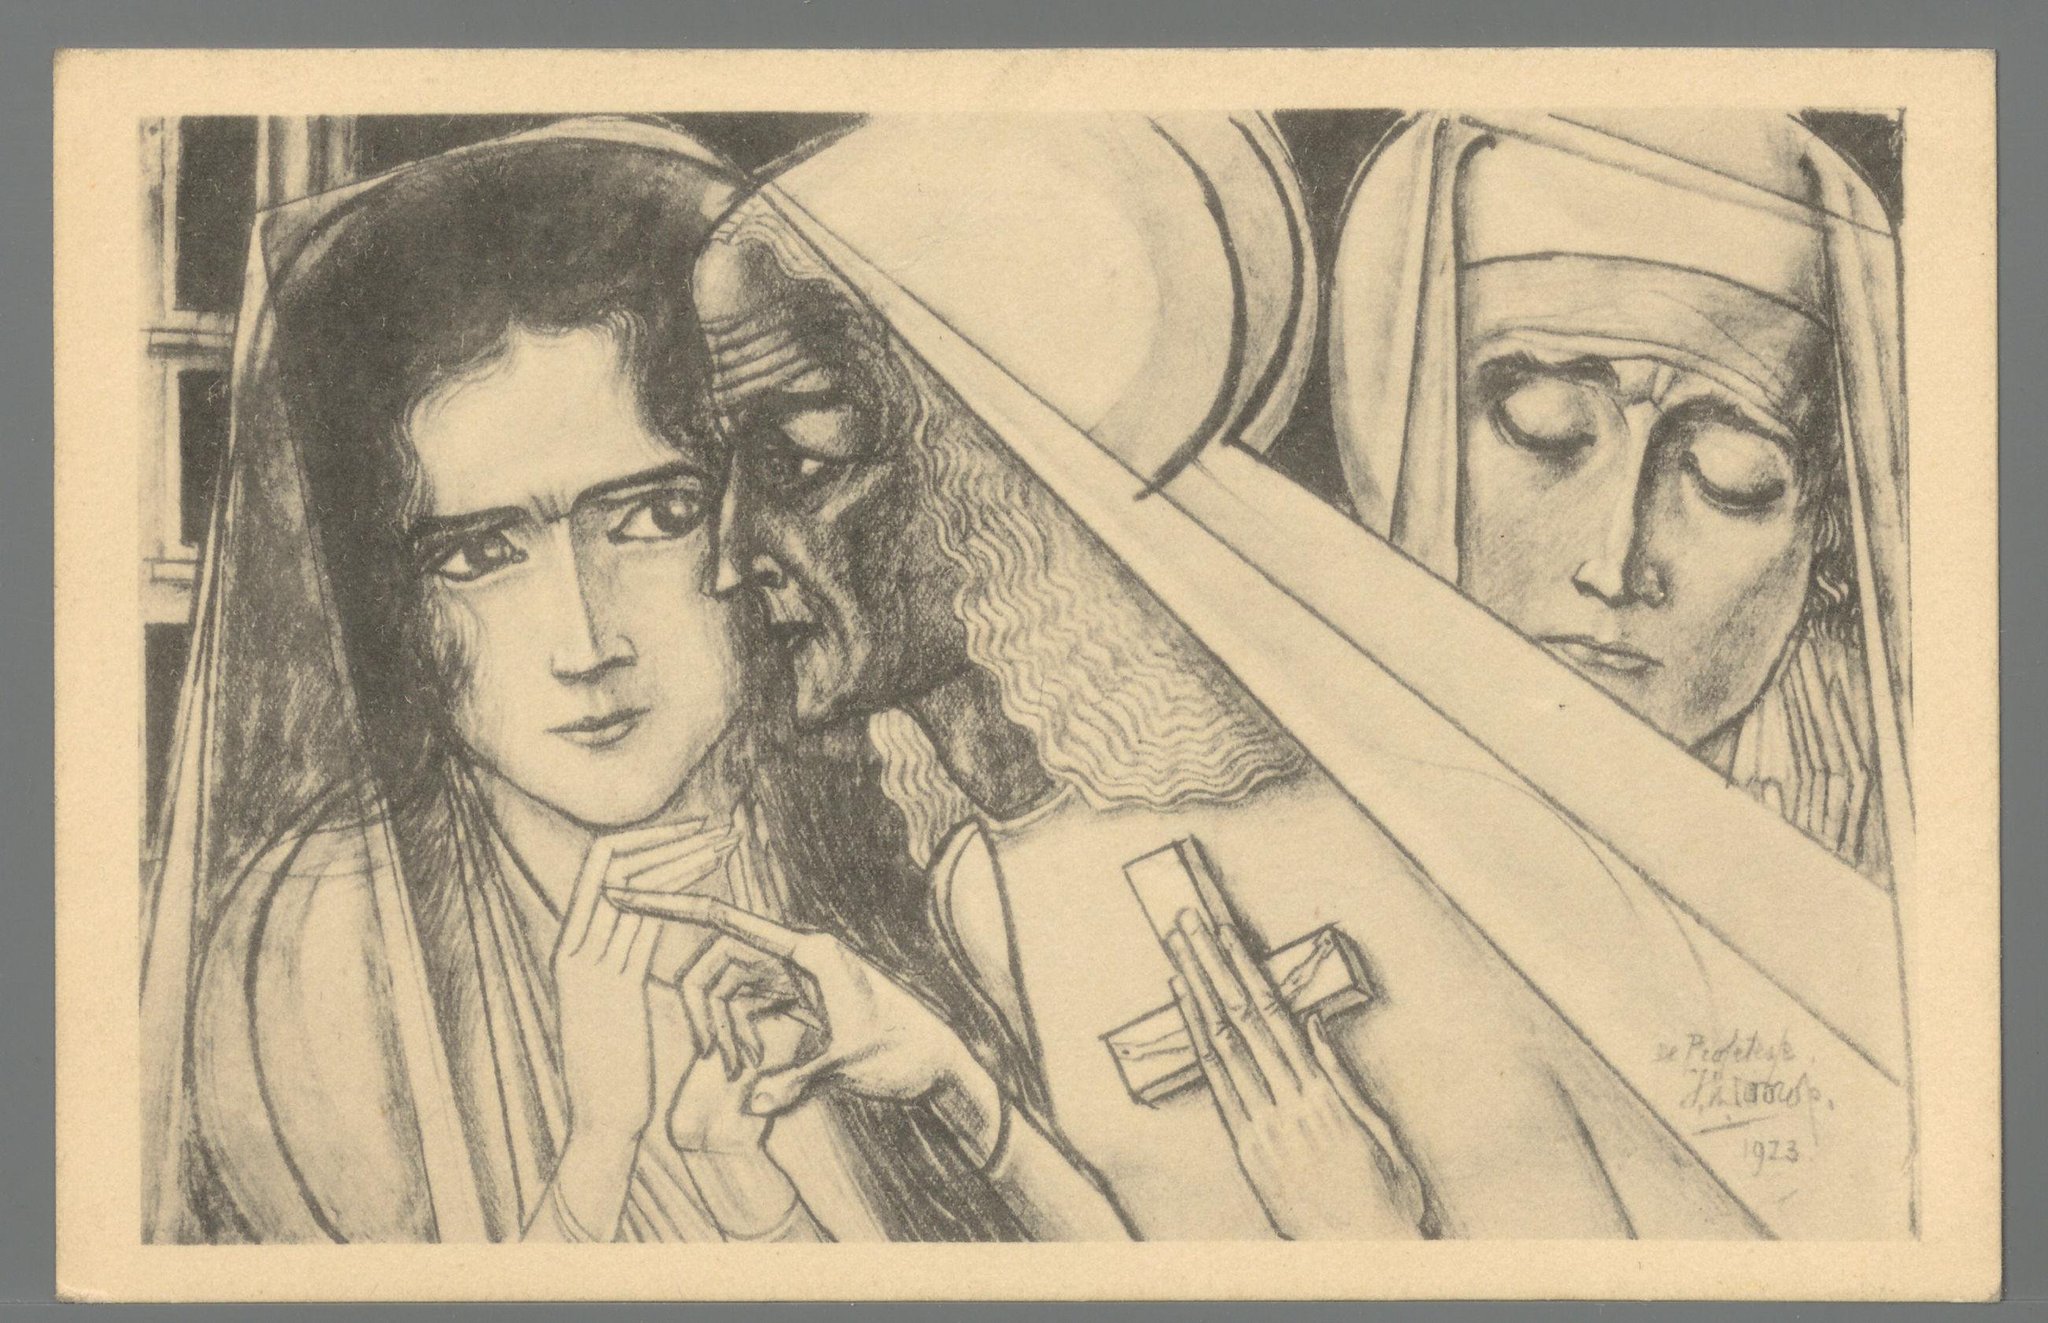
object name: photomechanical print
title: Jan Toorop. De profetesse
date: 1923-1935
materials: cardboard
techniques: photograph, writing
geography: amsterdam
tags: prophets, sibyls, evangelists, doctors of the church; persons ~ the bible (not in biblical context), adult woman (+ two persons)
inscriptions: postage stamp